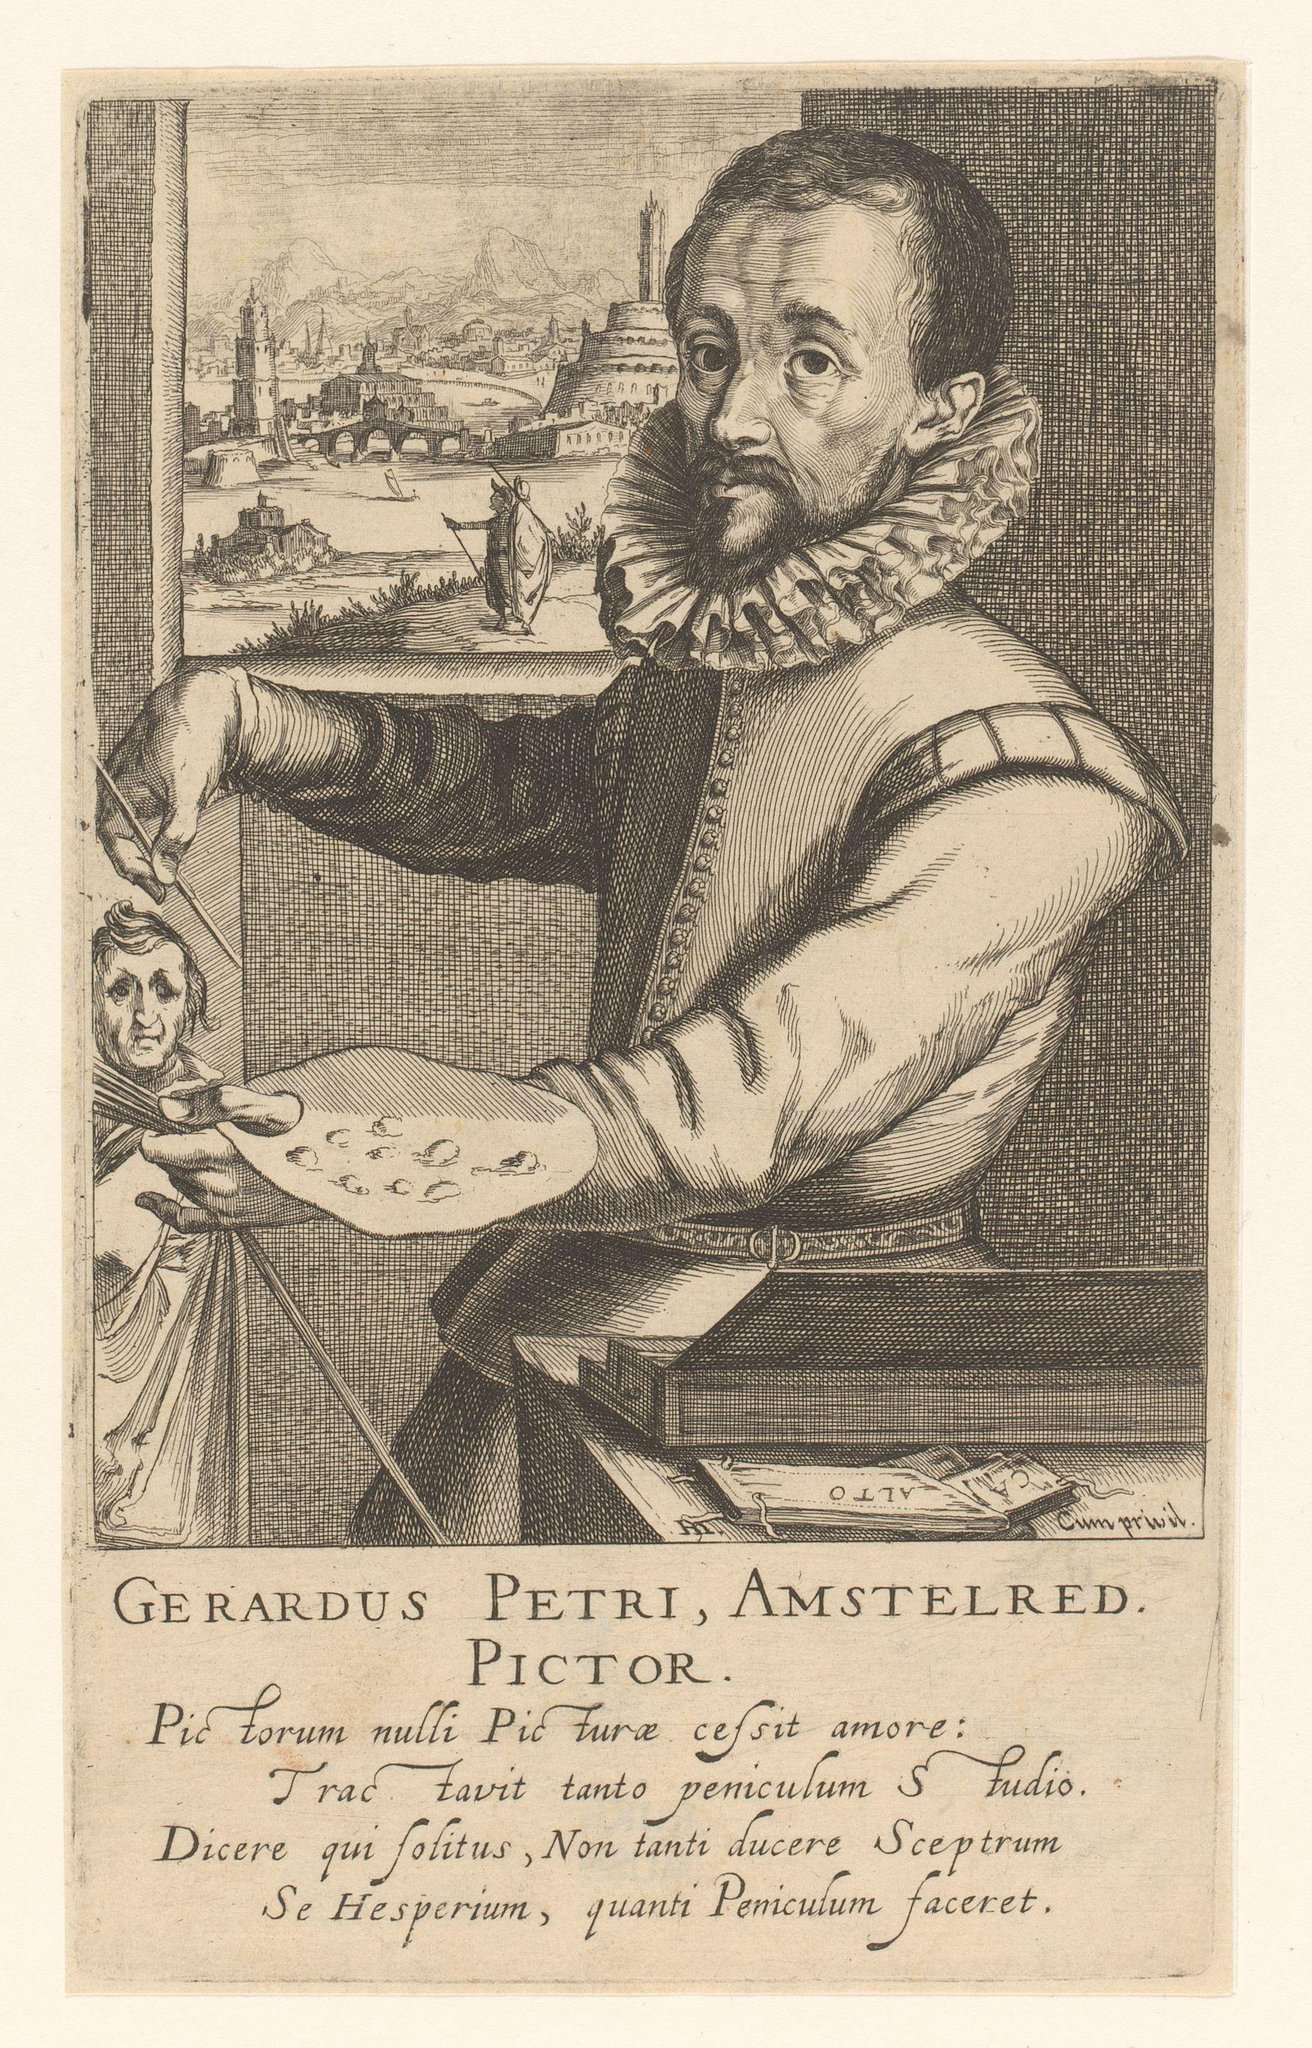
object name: print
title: Portret van Gerrit Pietersz. Sweelinck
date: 1610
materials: paper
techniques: engraving, etching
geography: the hague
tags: painter, gerrit pietersz. sweelink, historical persons, portrait, self-portrait of painter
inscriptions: collector's mark: Lugt 2760, collector's mark: Lugt 2166